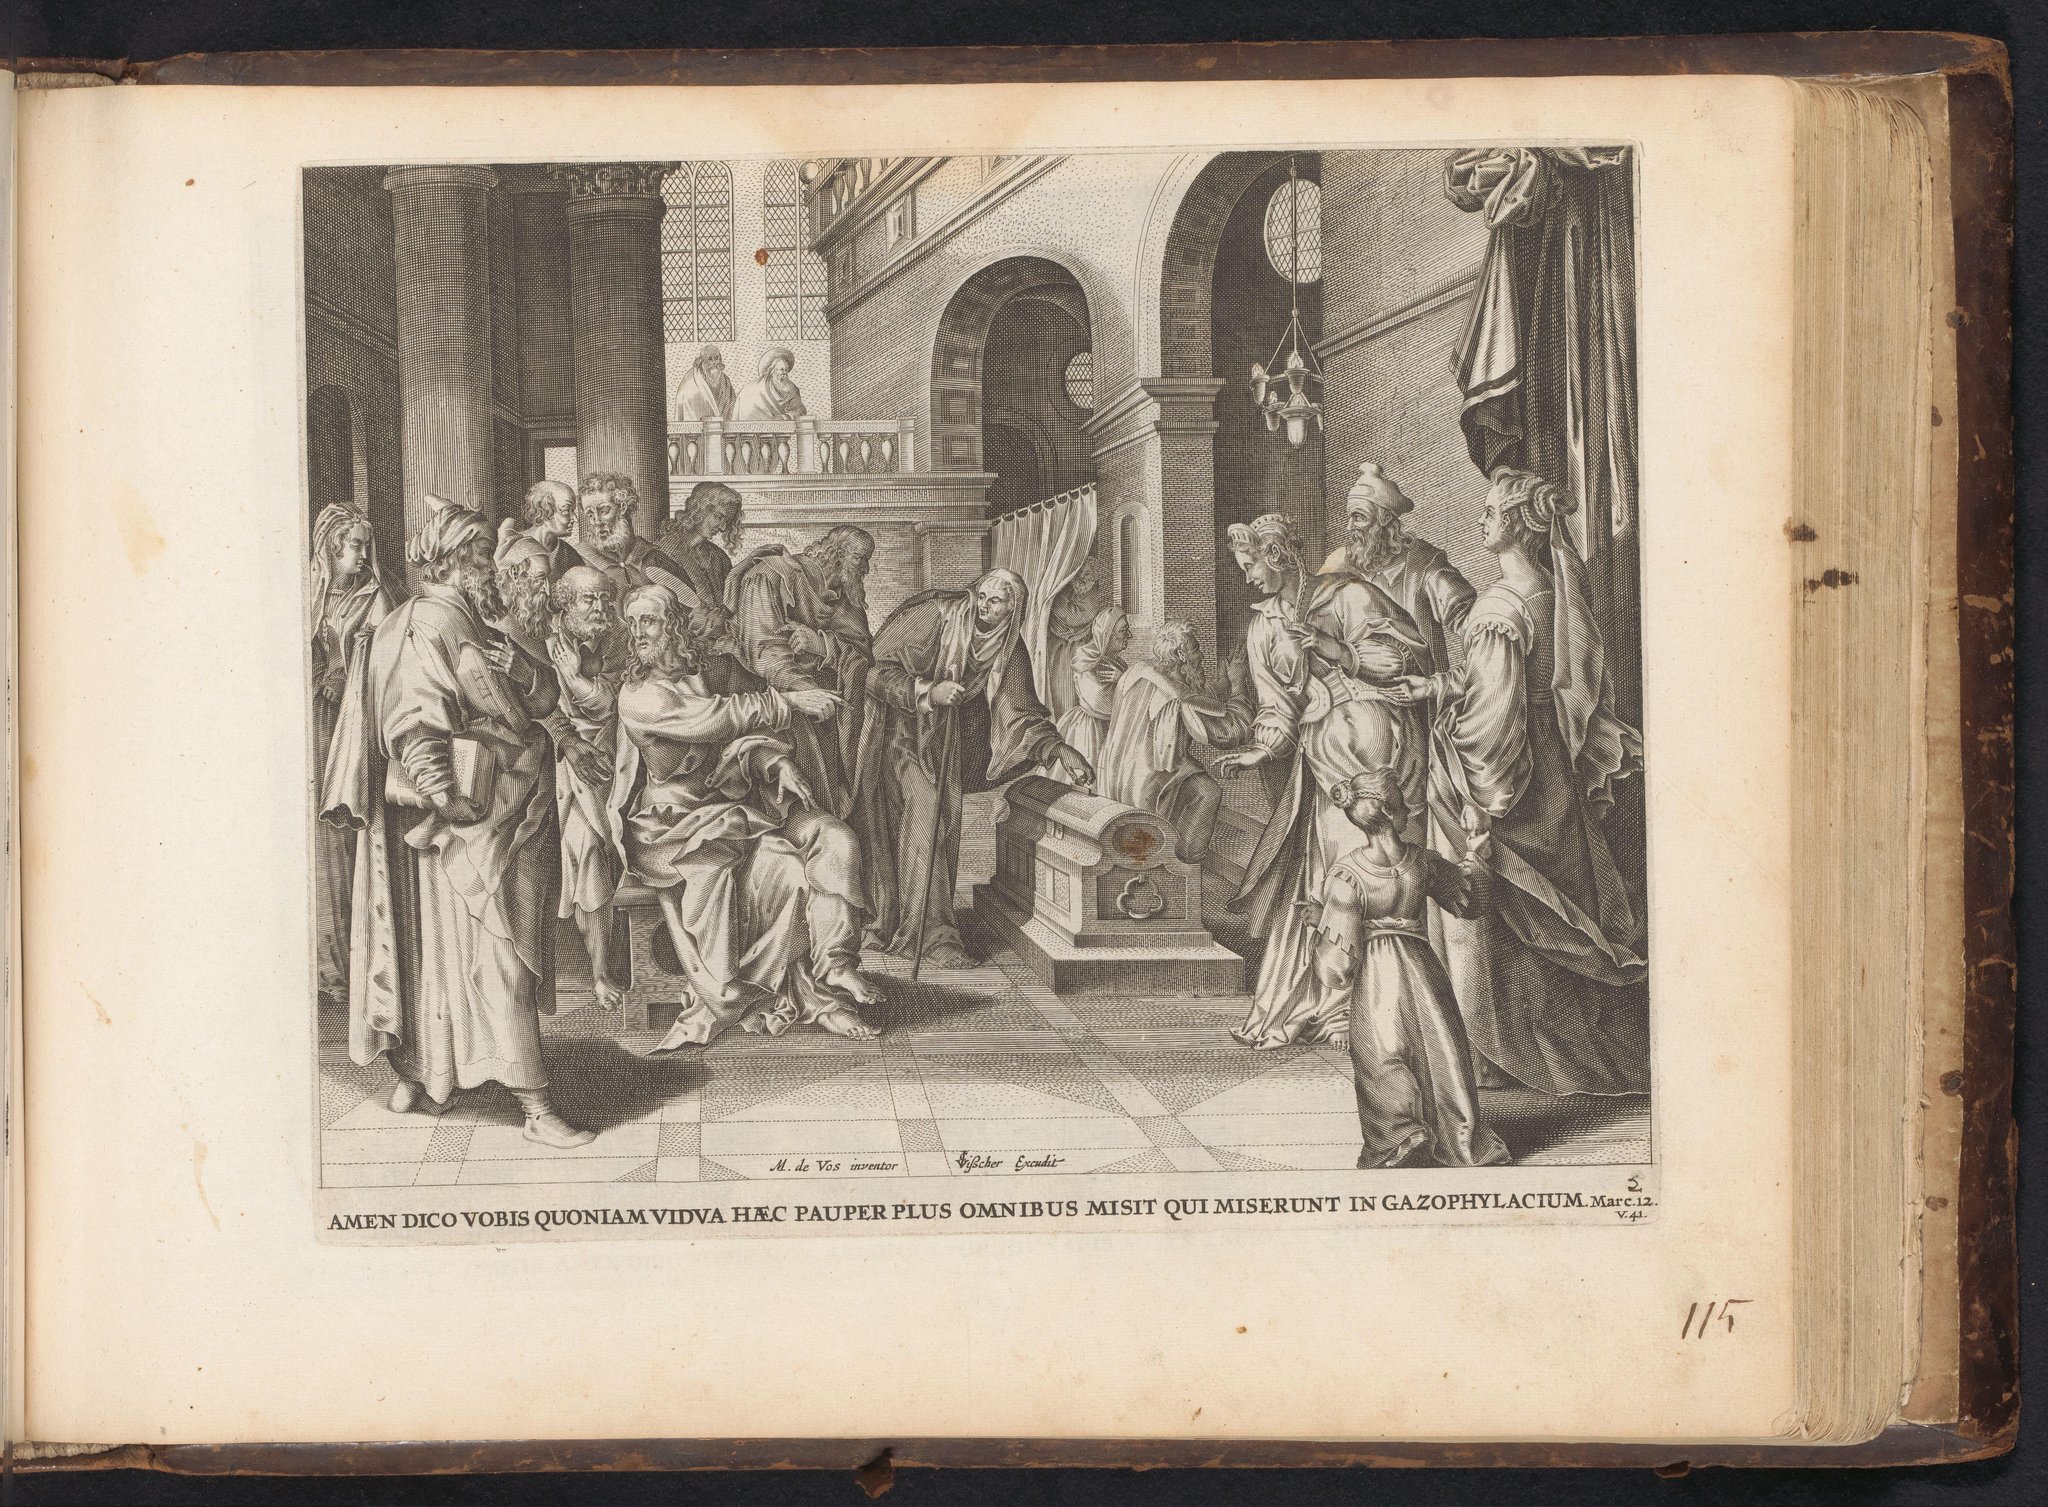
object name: album leaf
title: Vorder geschiedenissen binnen Ierusalem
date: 1646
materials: paper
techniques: engraving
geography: alkmaar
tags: the widow's mite: christ draws the disciples' attention to a woman who puts a few coins in the temple's money chest (mark 12:41-44; luke 21:1-4)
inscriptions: serial number: ‘2’, number: ‘115’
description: In de tempel zit links op de voorgrond Christus, die twee van zijn leerlingen wijst op een gesluierde arme weduwe. Rijk geklede mensen lopen toe op de offerkist om er veel geld in te werpen. De weduwe heeft er slechts twee muntjes ingegooid, maar dat is volgens Christus meer dan de rijken doen, omdat ze van haar armoede heeft gegeven. Onder de voorstelling een verwijzing in het Latijn naar de Bijbeltekst in Mar. 12:41. Deze prent maakt deel uit van een album.